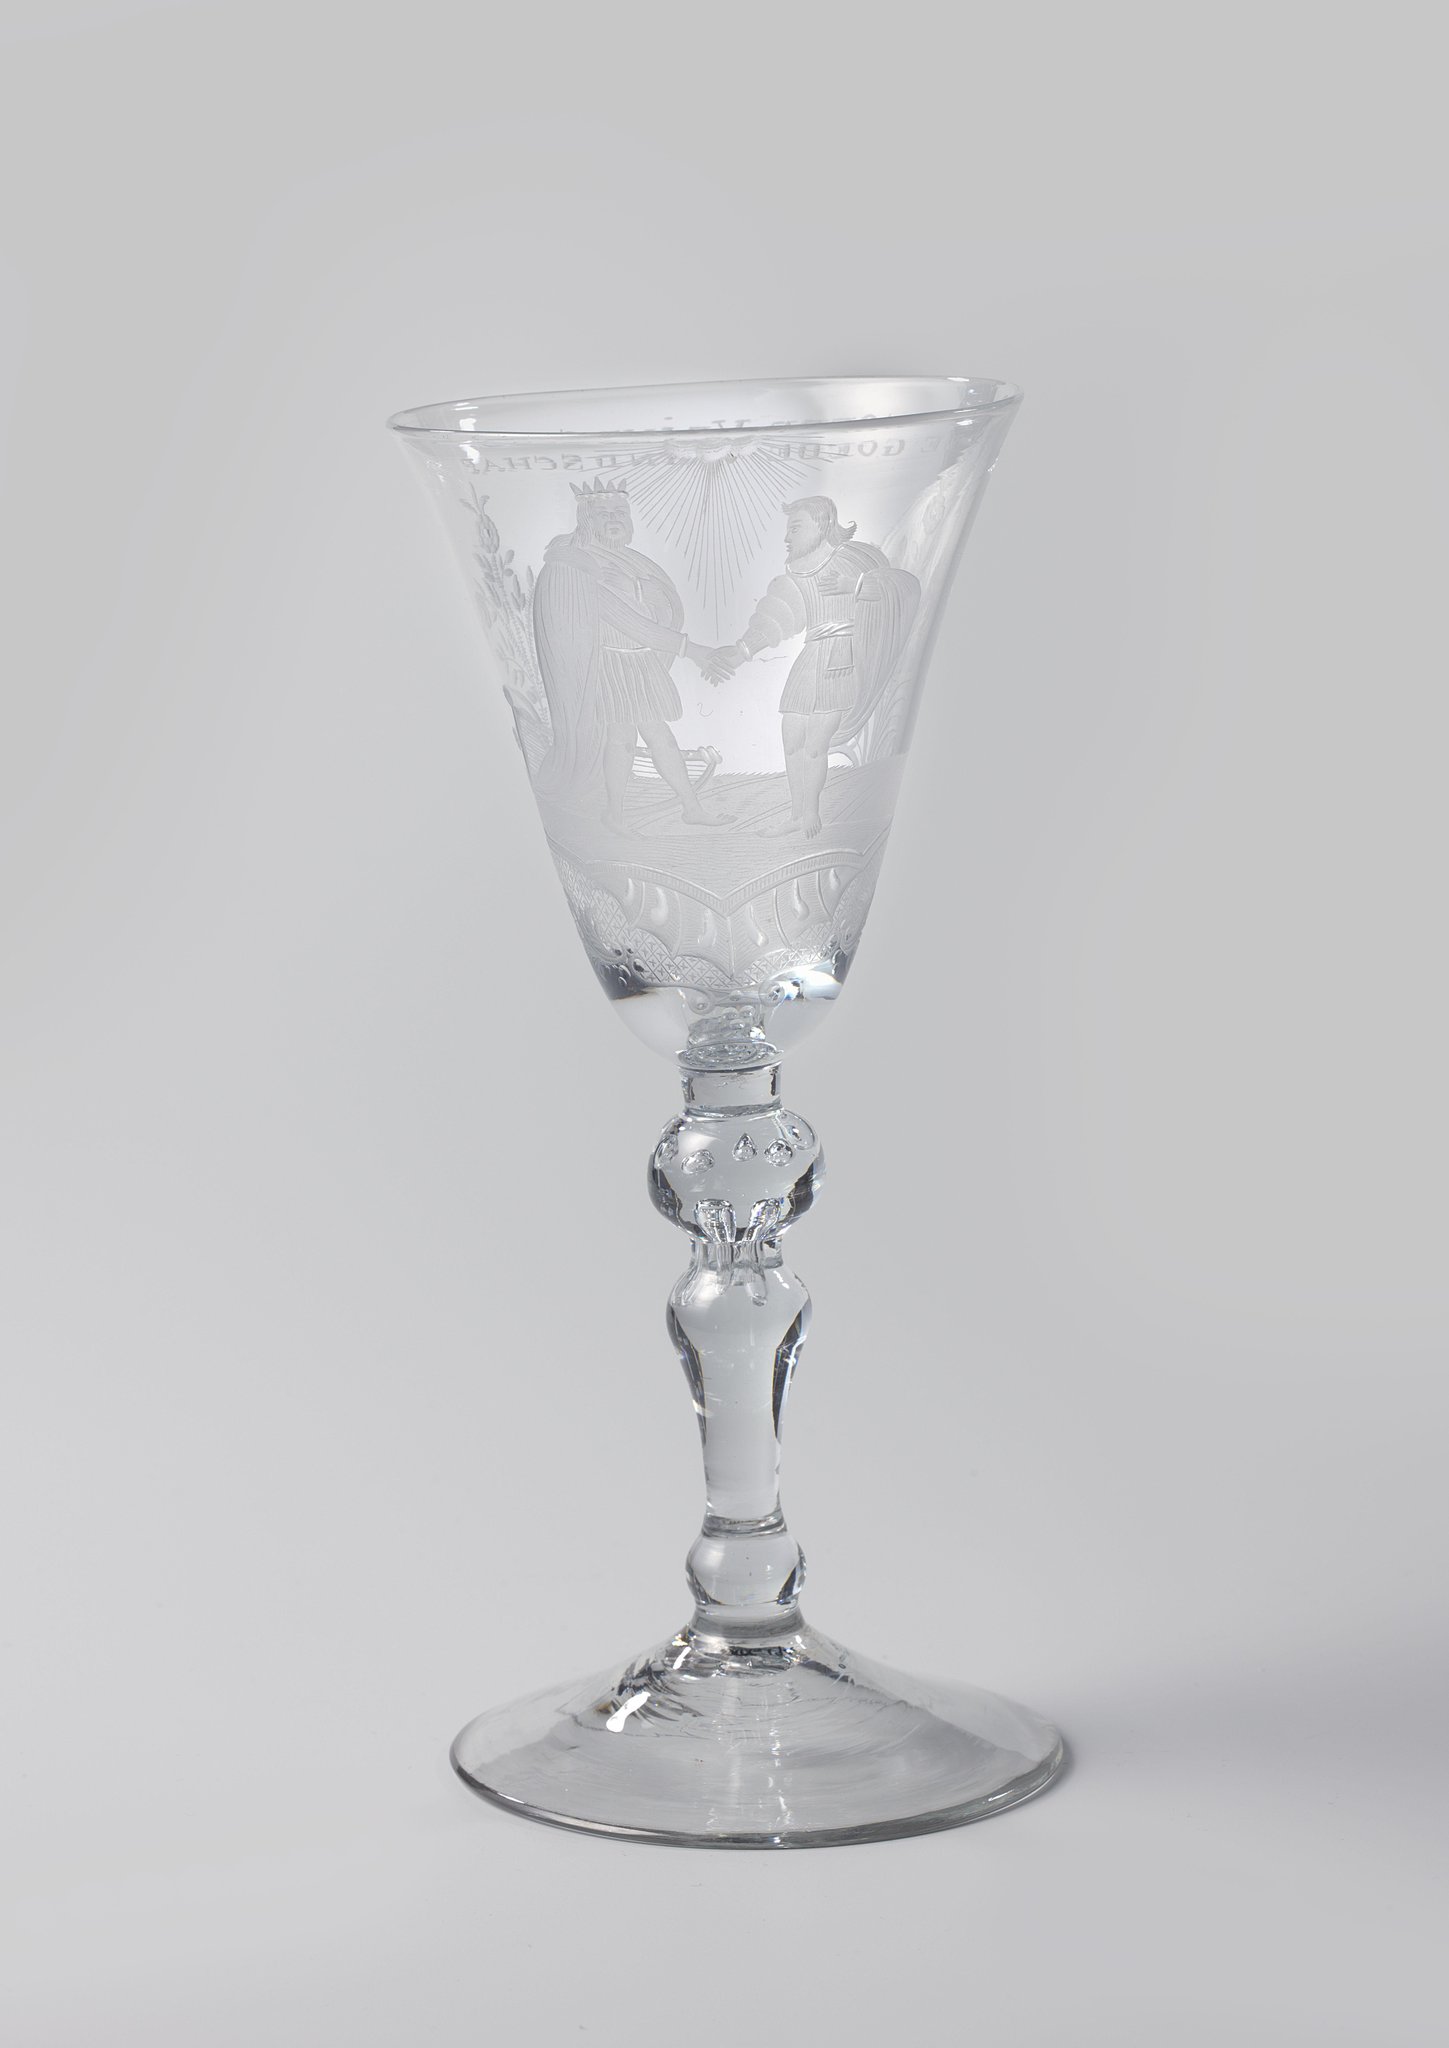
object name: goblet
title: Kelkglas met David en Jonathan en het opschrift: DE GOEDE VRINDSCHAP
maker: Anonymous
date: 1750-1775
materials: glass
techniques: glassblowing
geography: northern netherlands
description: David and Jonathan, c. 1750 - 1775. On loan from the Koninklijk Oudheidkundig Genootschap.